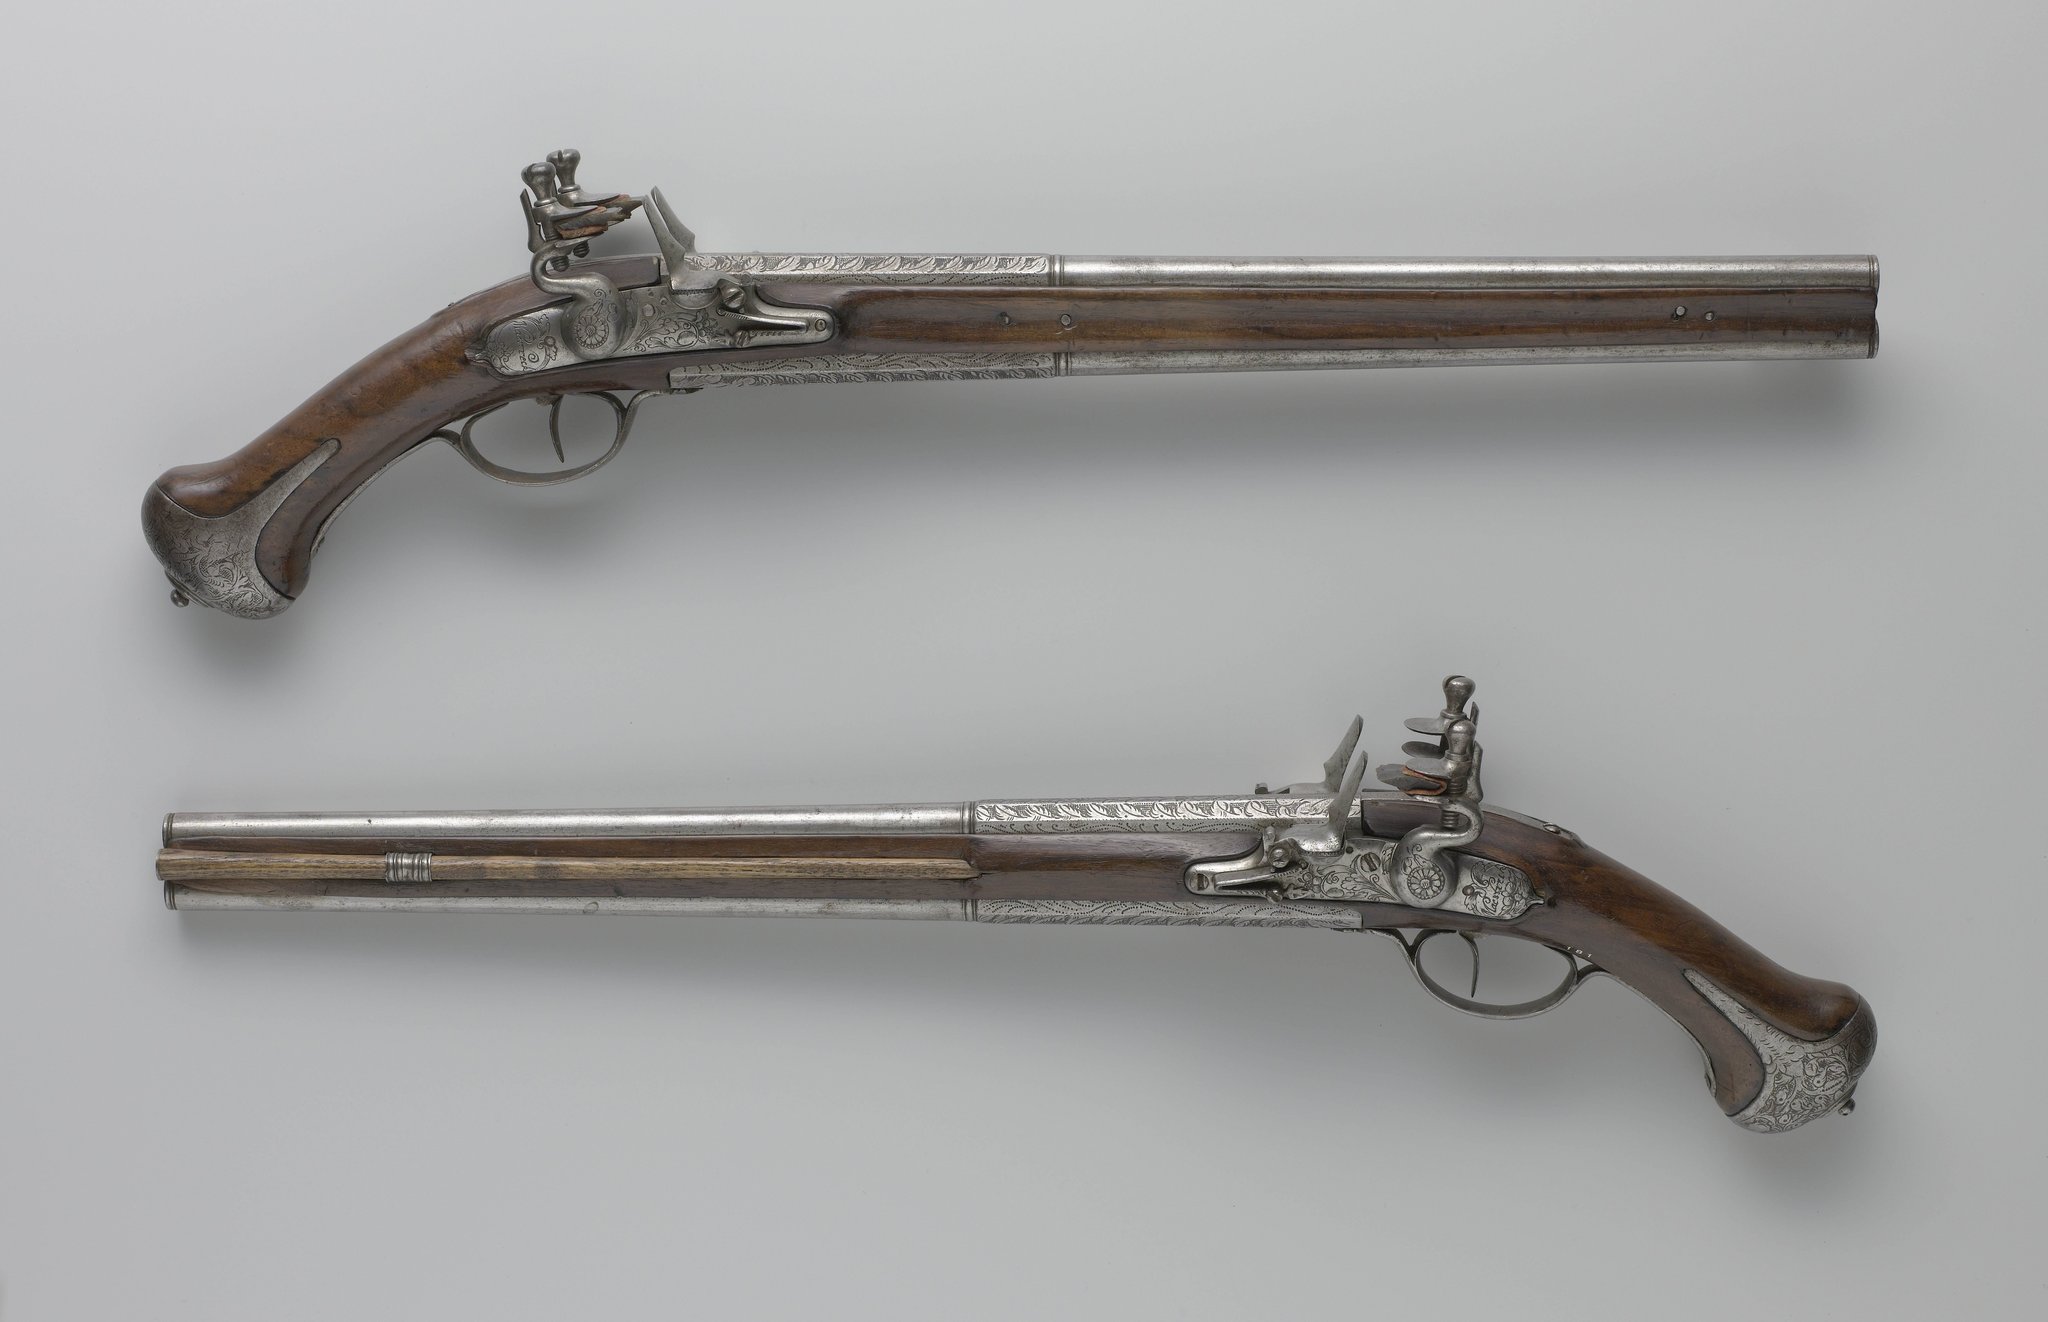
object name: flintlock pistol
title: Dubbelloops vuursteenpistool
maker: Anonymous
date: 1660-1665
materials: iron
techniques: engraving, granulation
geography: maastricht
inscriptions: inscription: ‘Maestreck’